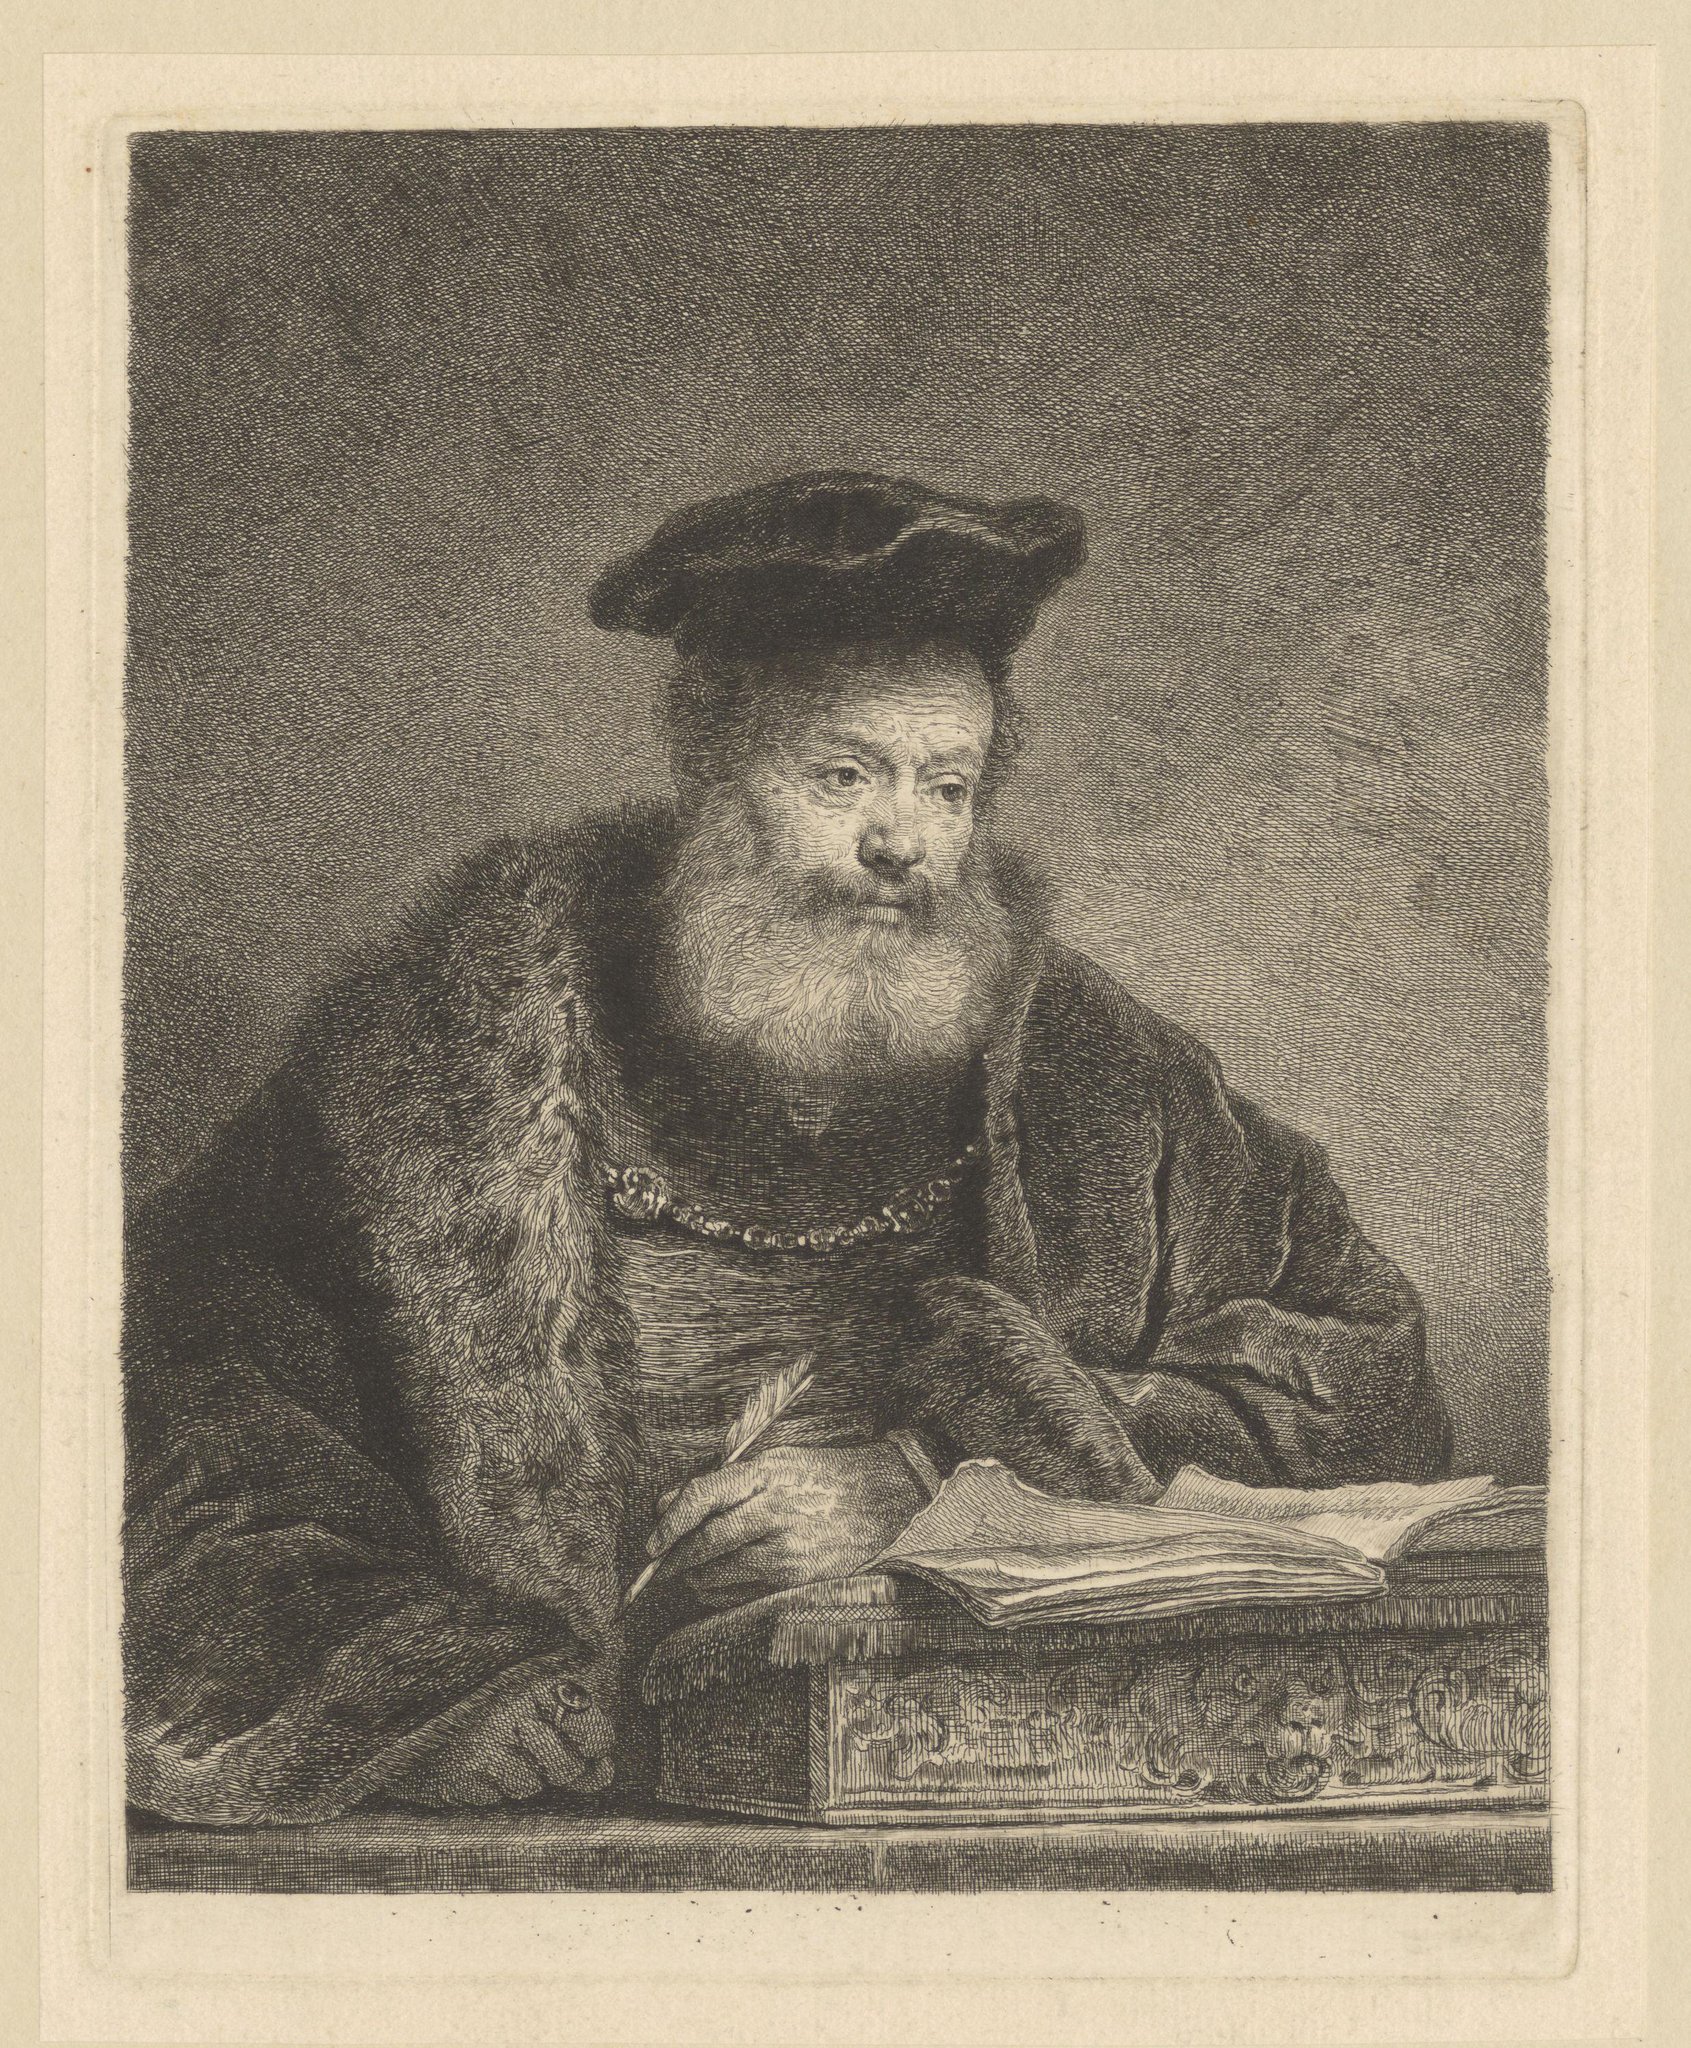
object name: print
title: Geleerde aan een lessenaar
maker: georg friedrich schmidt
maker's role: draughtsman, print maker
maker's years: 1712-1775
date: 1770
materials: paper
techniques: etching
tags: scholar in his study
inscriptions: collector's mark: Lugt 240